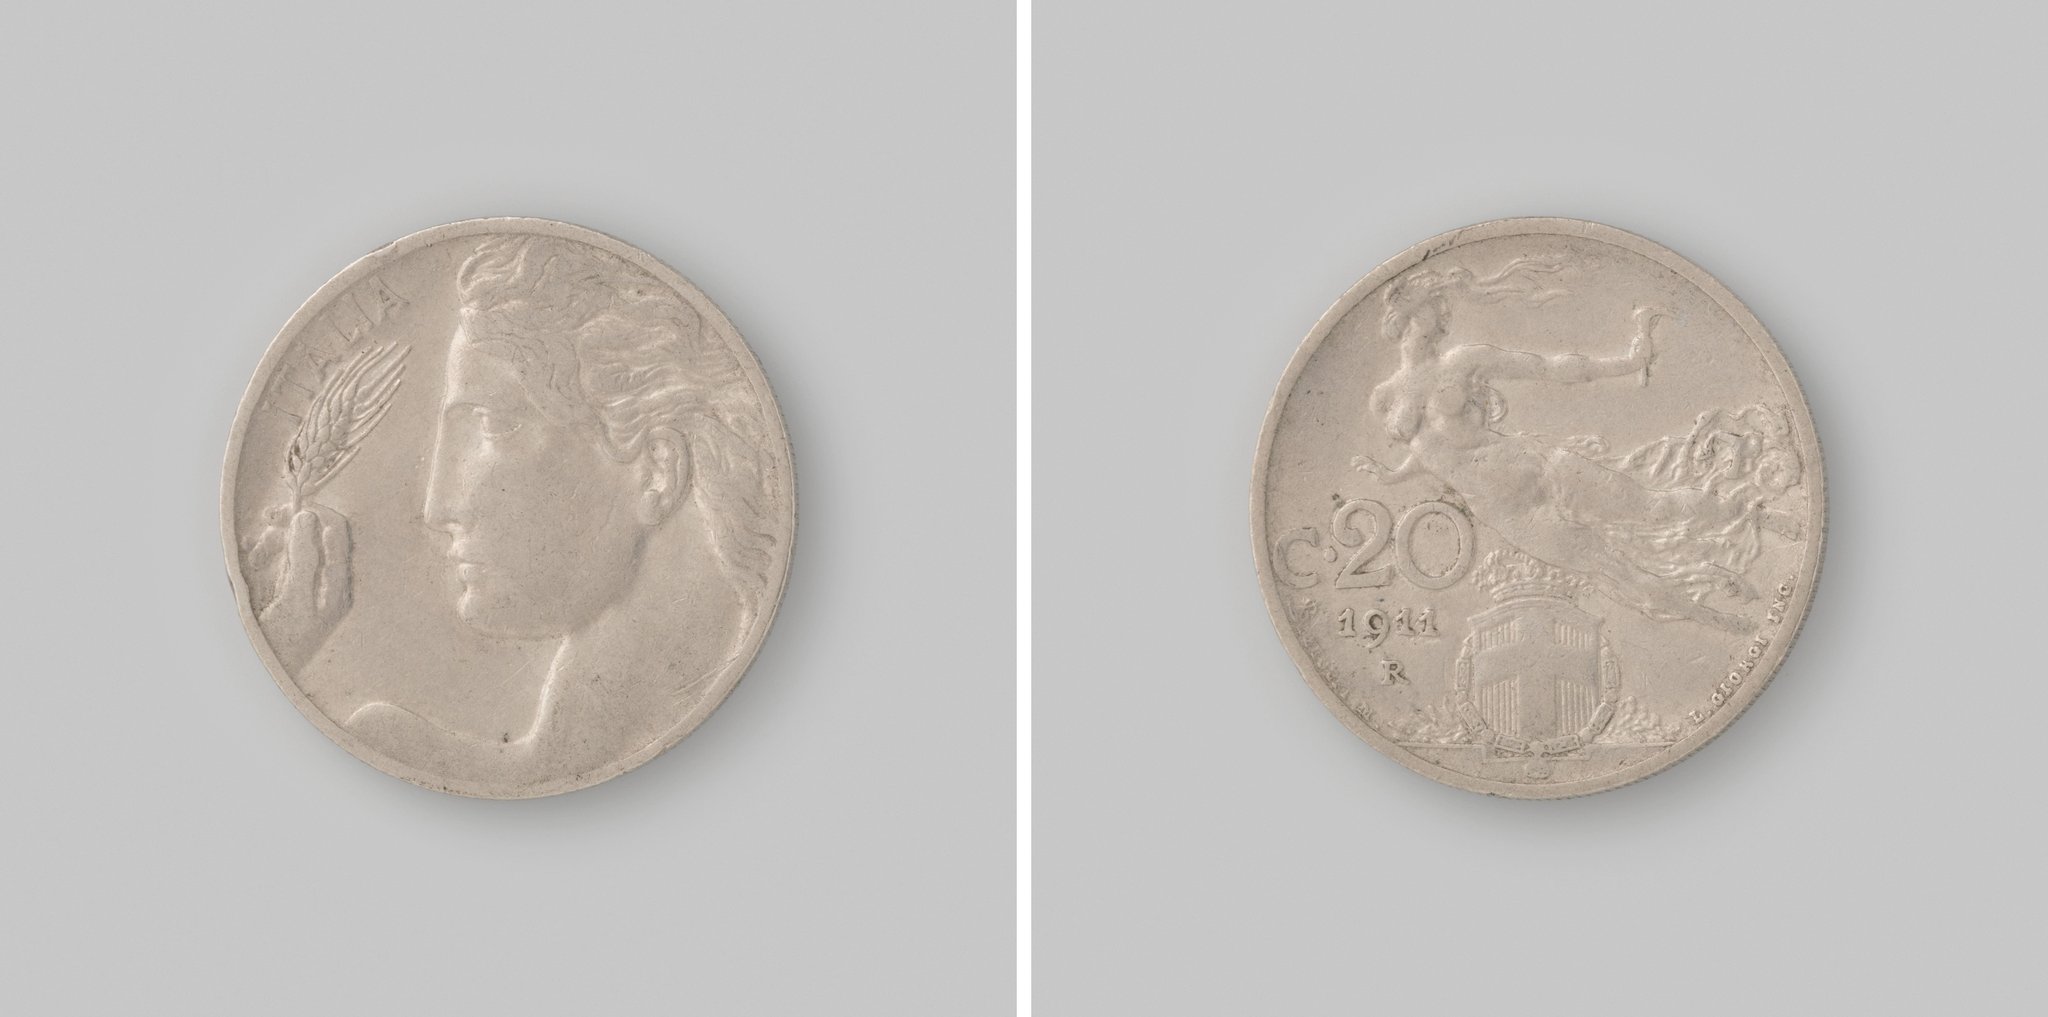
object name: coin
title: 20 centesimi uit Italië van koning Vittorio Emanuele III, 1911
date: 1911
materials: nickel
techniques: striking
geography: rome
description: Nikkelen munt. Voorzijde: portret van een vrouw naar links met in haar rechterhand korenaar. Keerzijde: tussen twee takken met bladeren door keten van een orde met versiersel omhangen gekroond wapenschild van Italië. Daarboven in de lucht zwevende vrouwenfiguur met in haar linkerhand brandende toorts. Links van haar waarde-aanduiding: c. 20. Daaronder jaartal, waaronder muntteken: letter R [=Rome]. Kartelrand.